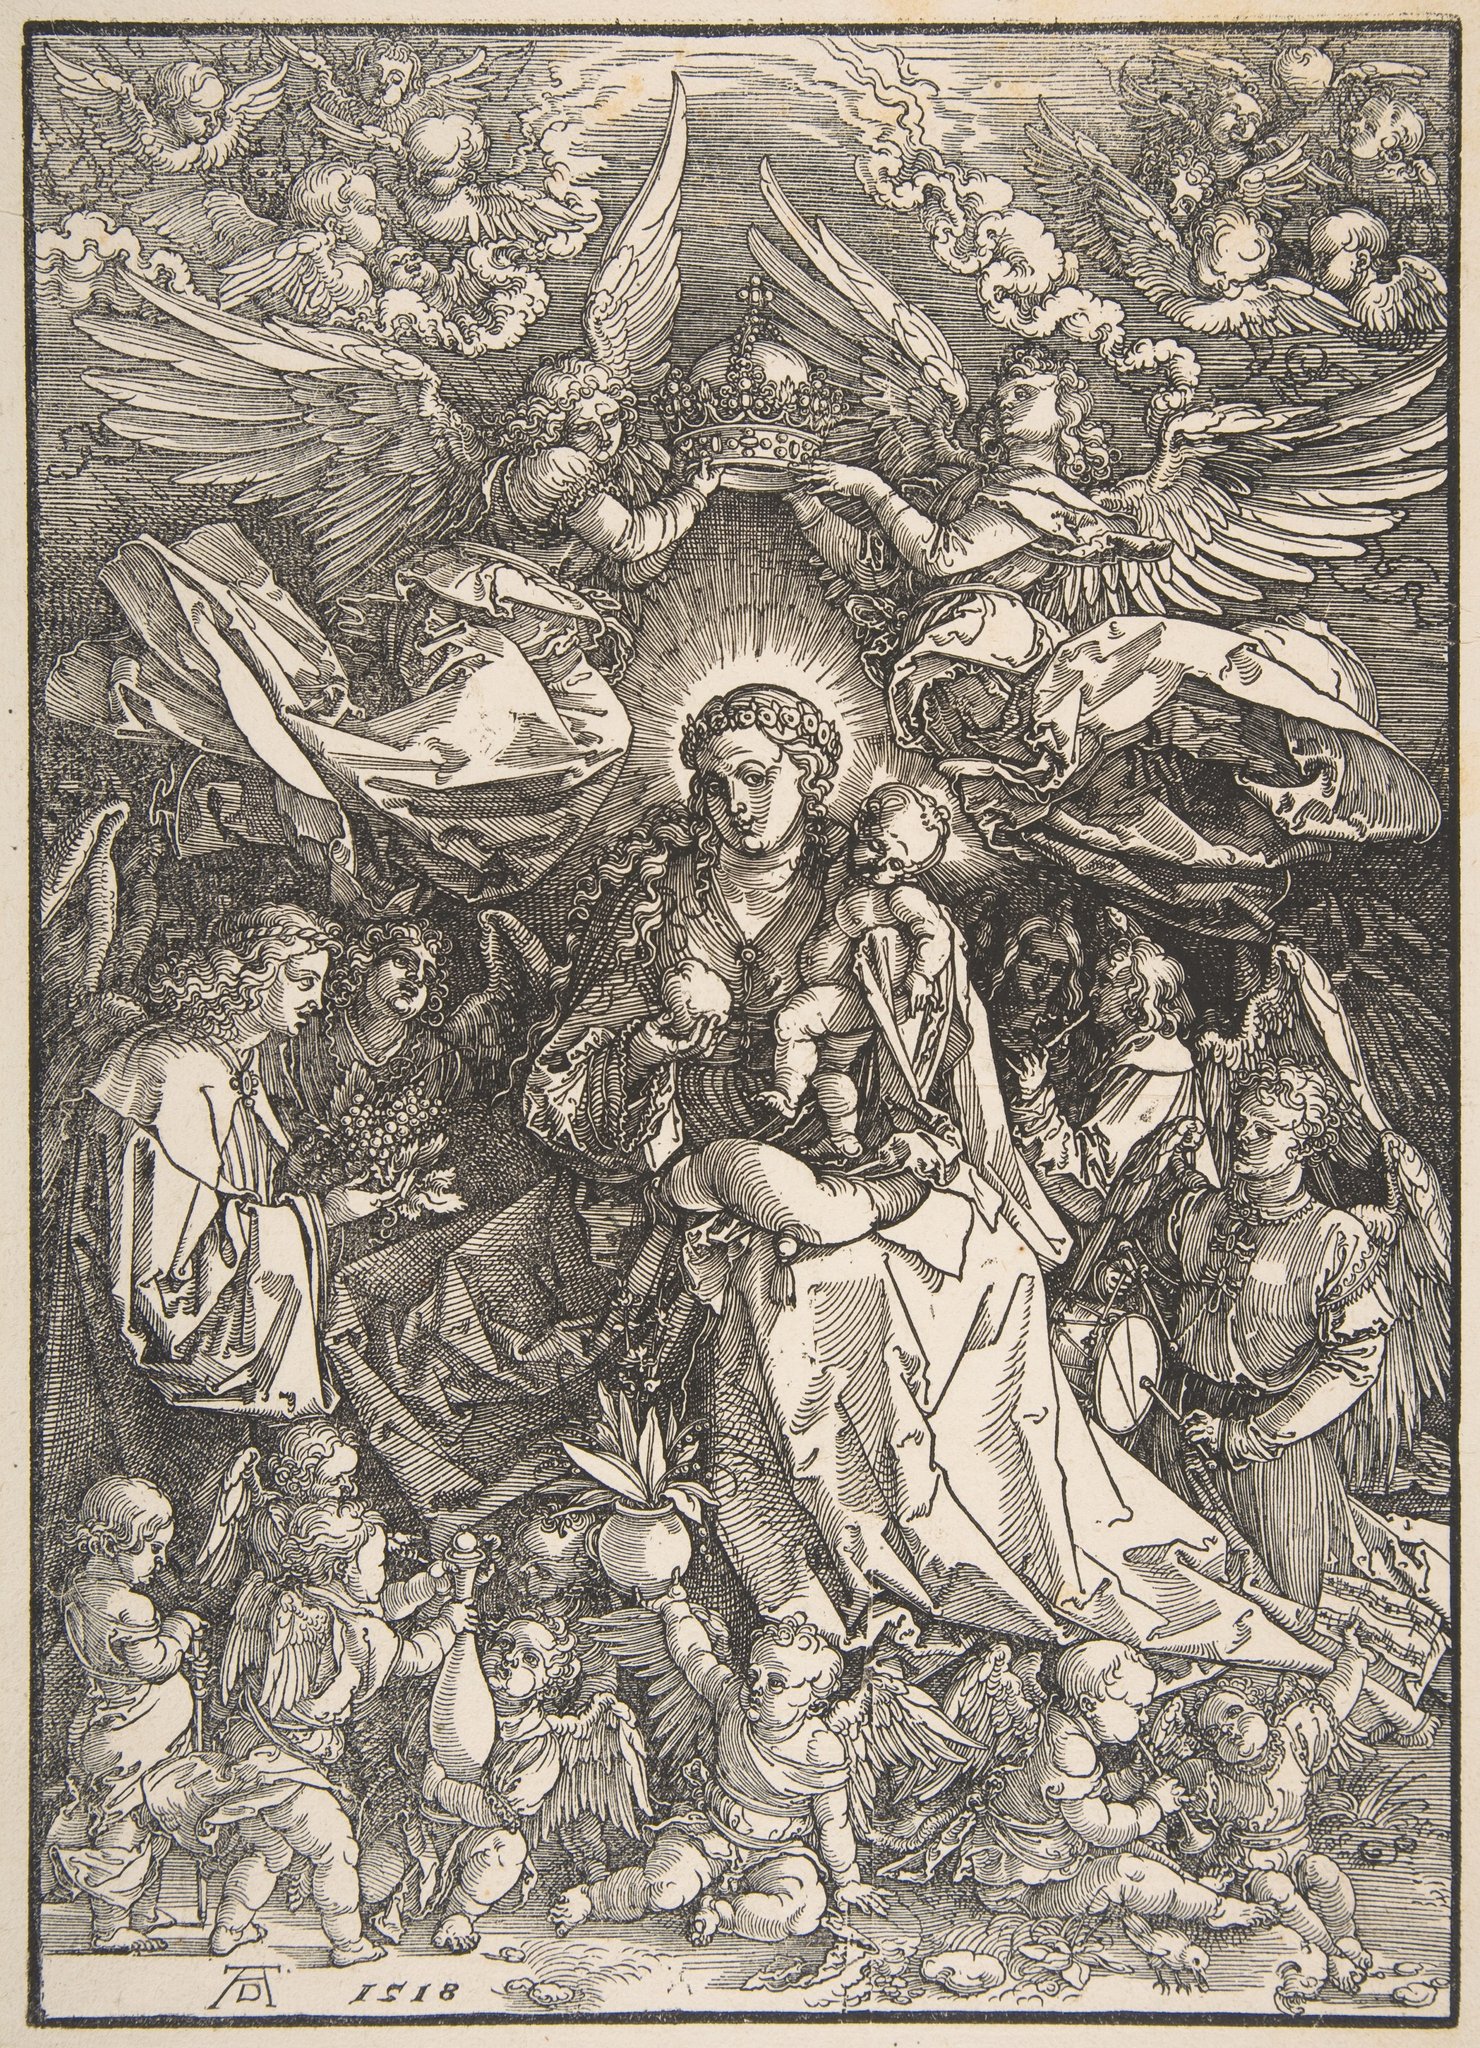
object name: print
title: The Virgin Surrounded by Many Angels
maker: albrecht dürer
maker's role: artist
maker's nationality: german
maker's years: 1471-1528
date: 1518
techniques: woodcut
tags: musical instruments,angels,madonna and child